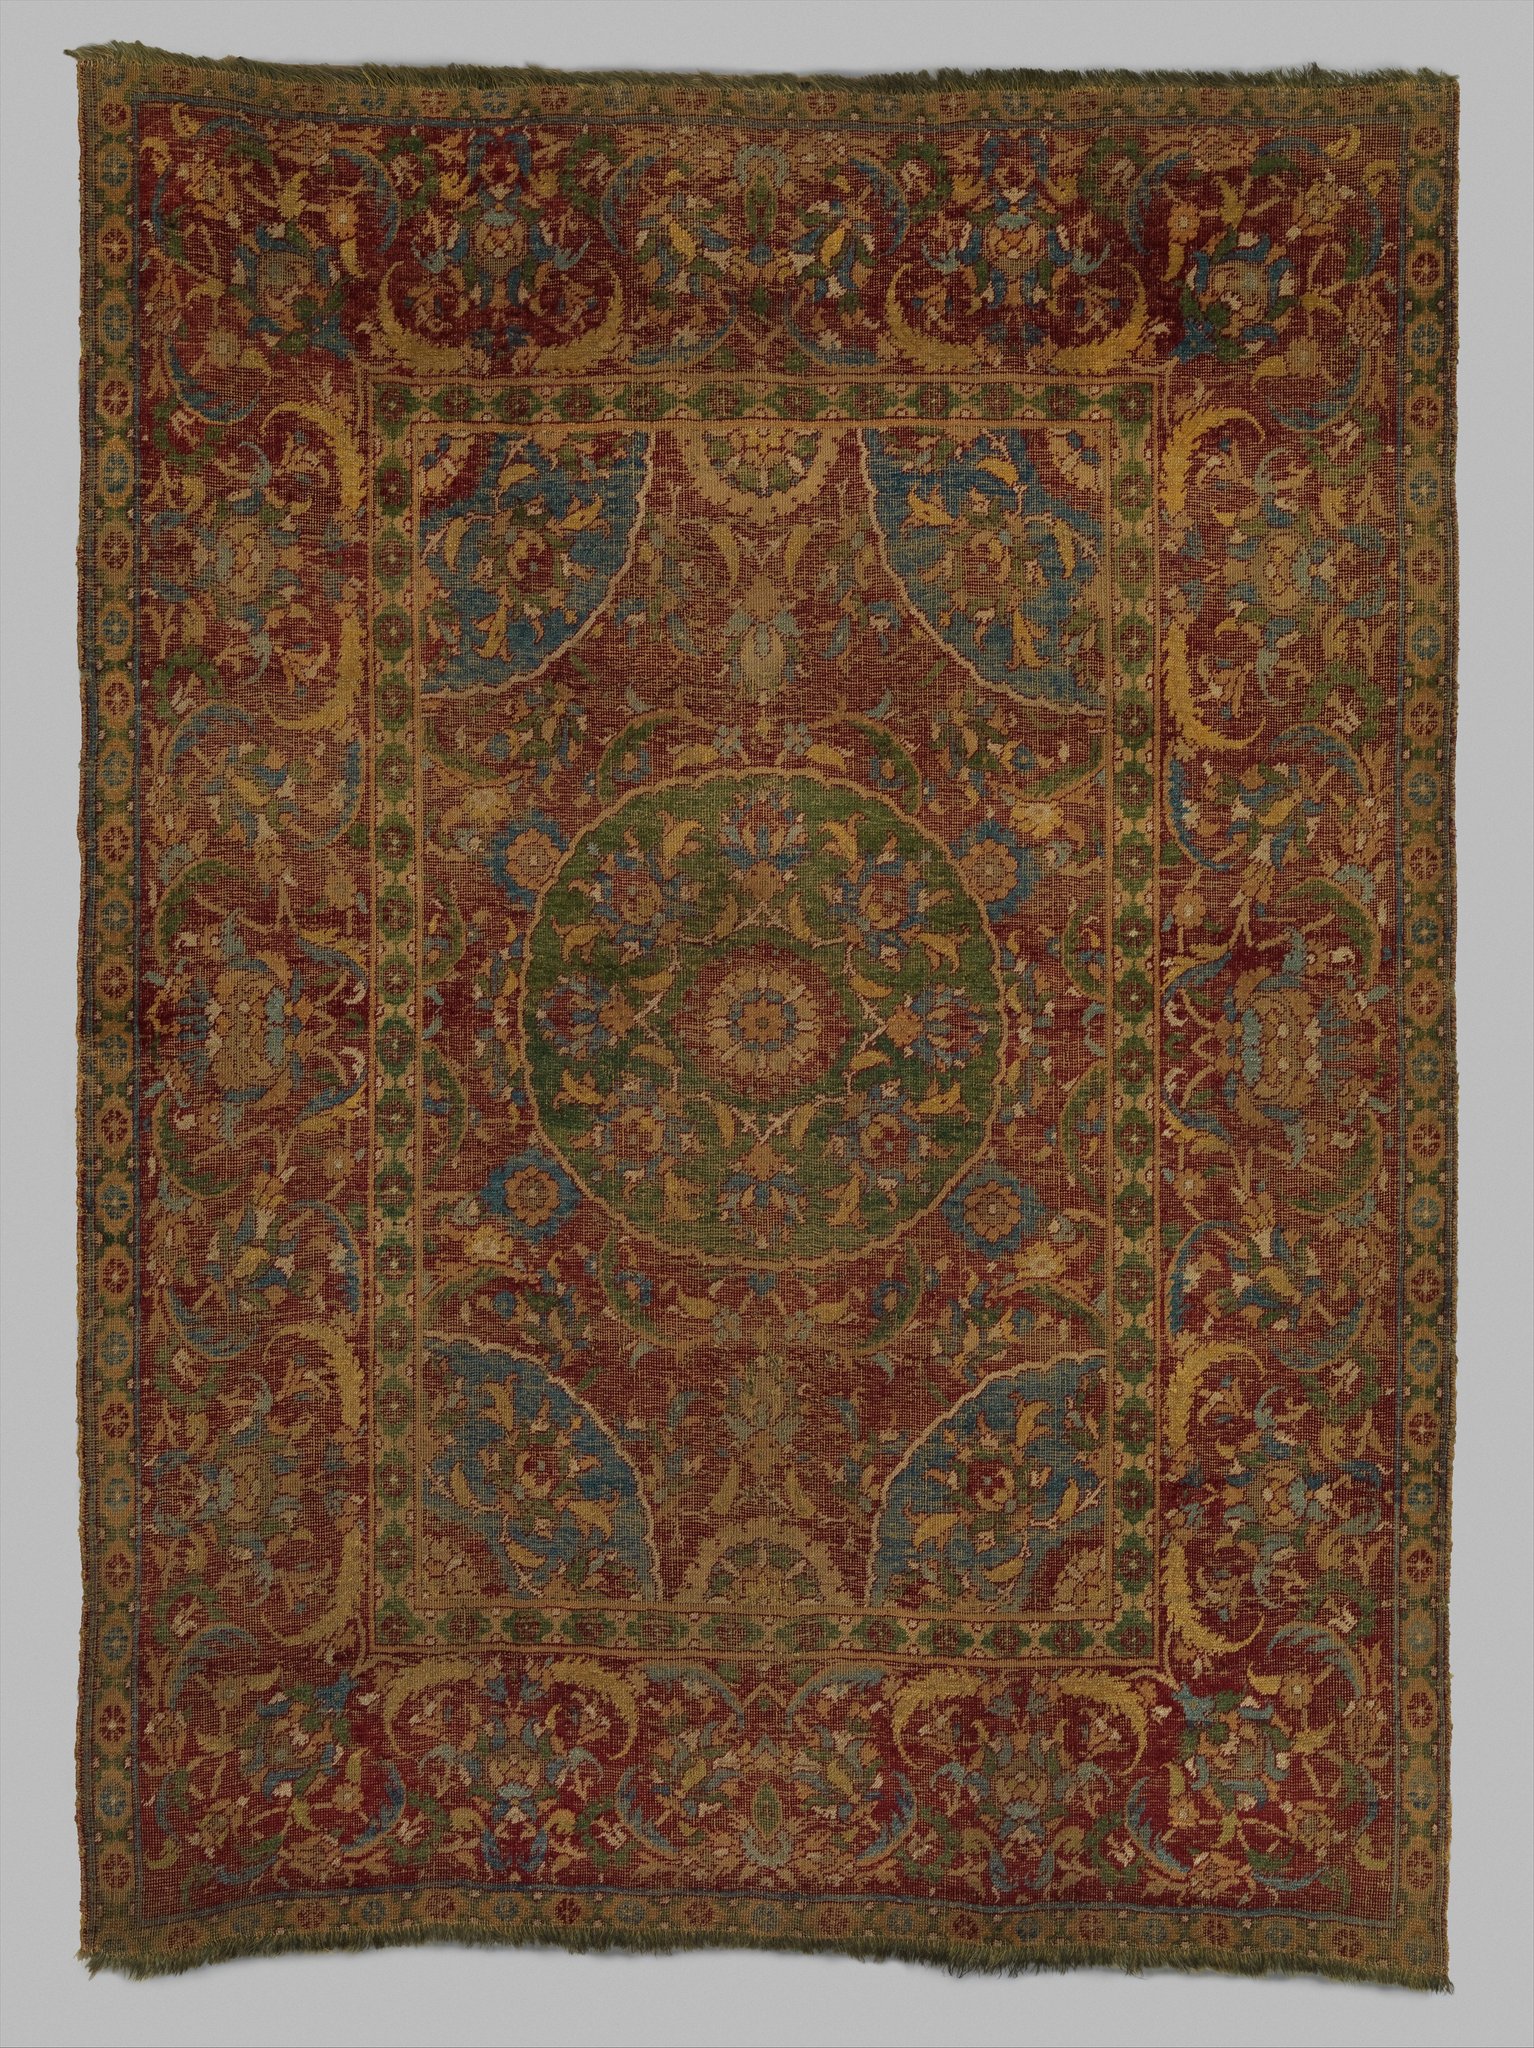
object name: carpet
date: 1601-1700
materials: wool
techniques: asymmetrically knotted pile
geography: egypt